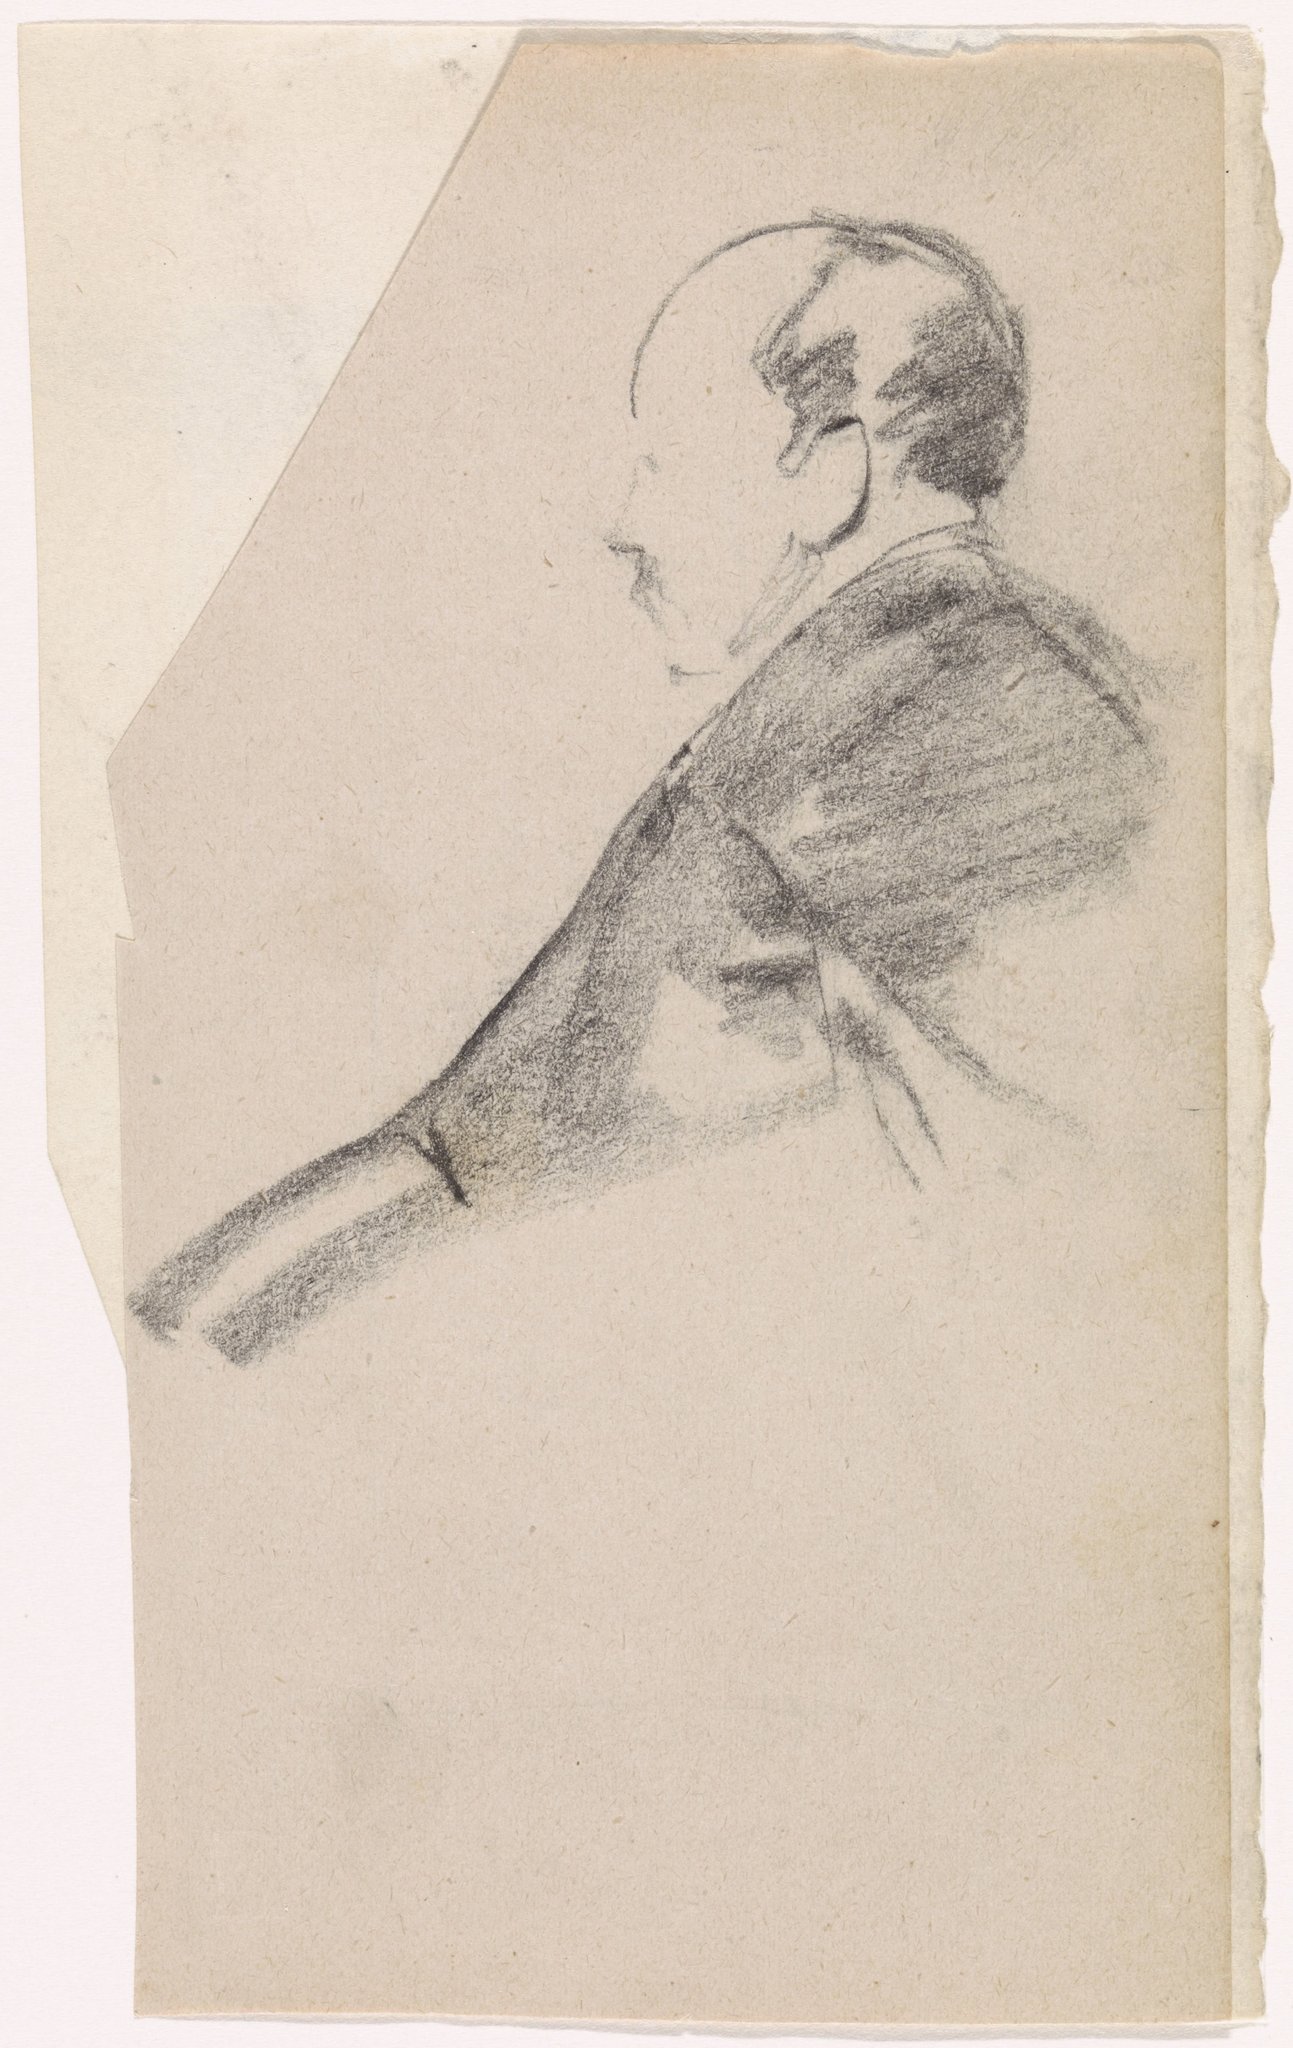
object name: drawing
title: Zittende man, deels van achteren gezien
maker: gerrit willem dijsselhof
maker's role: designer, draughtsman, print maker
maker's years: 1866-1924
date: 1876-1924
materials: chalk, paper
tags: anonymous historical person portrayed alone